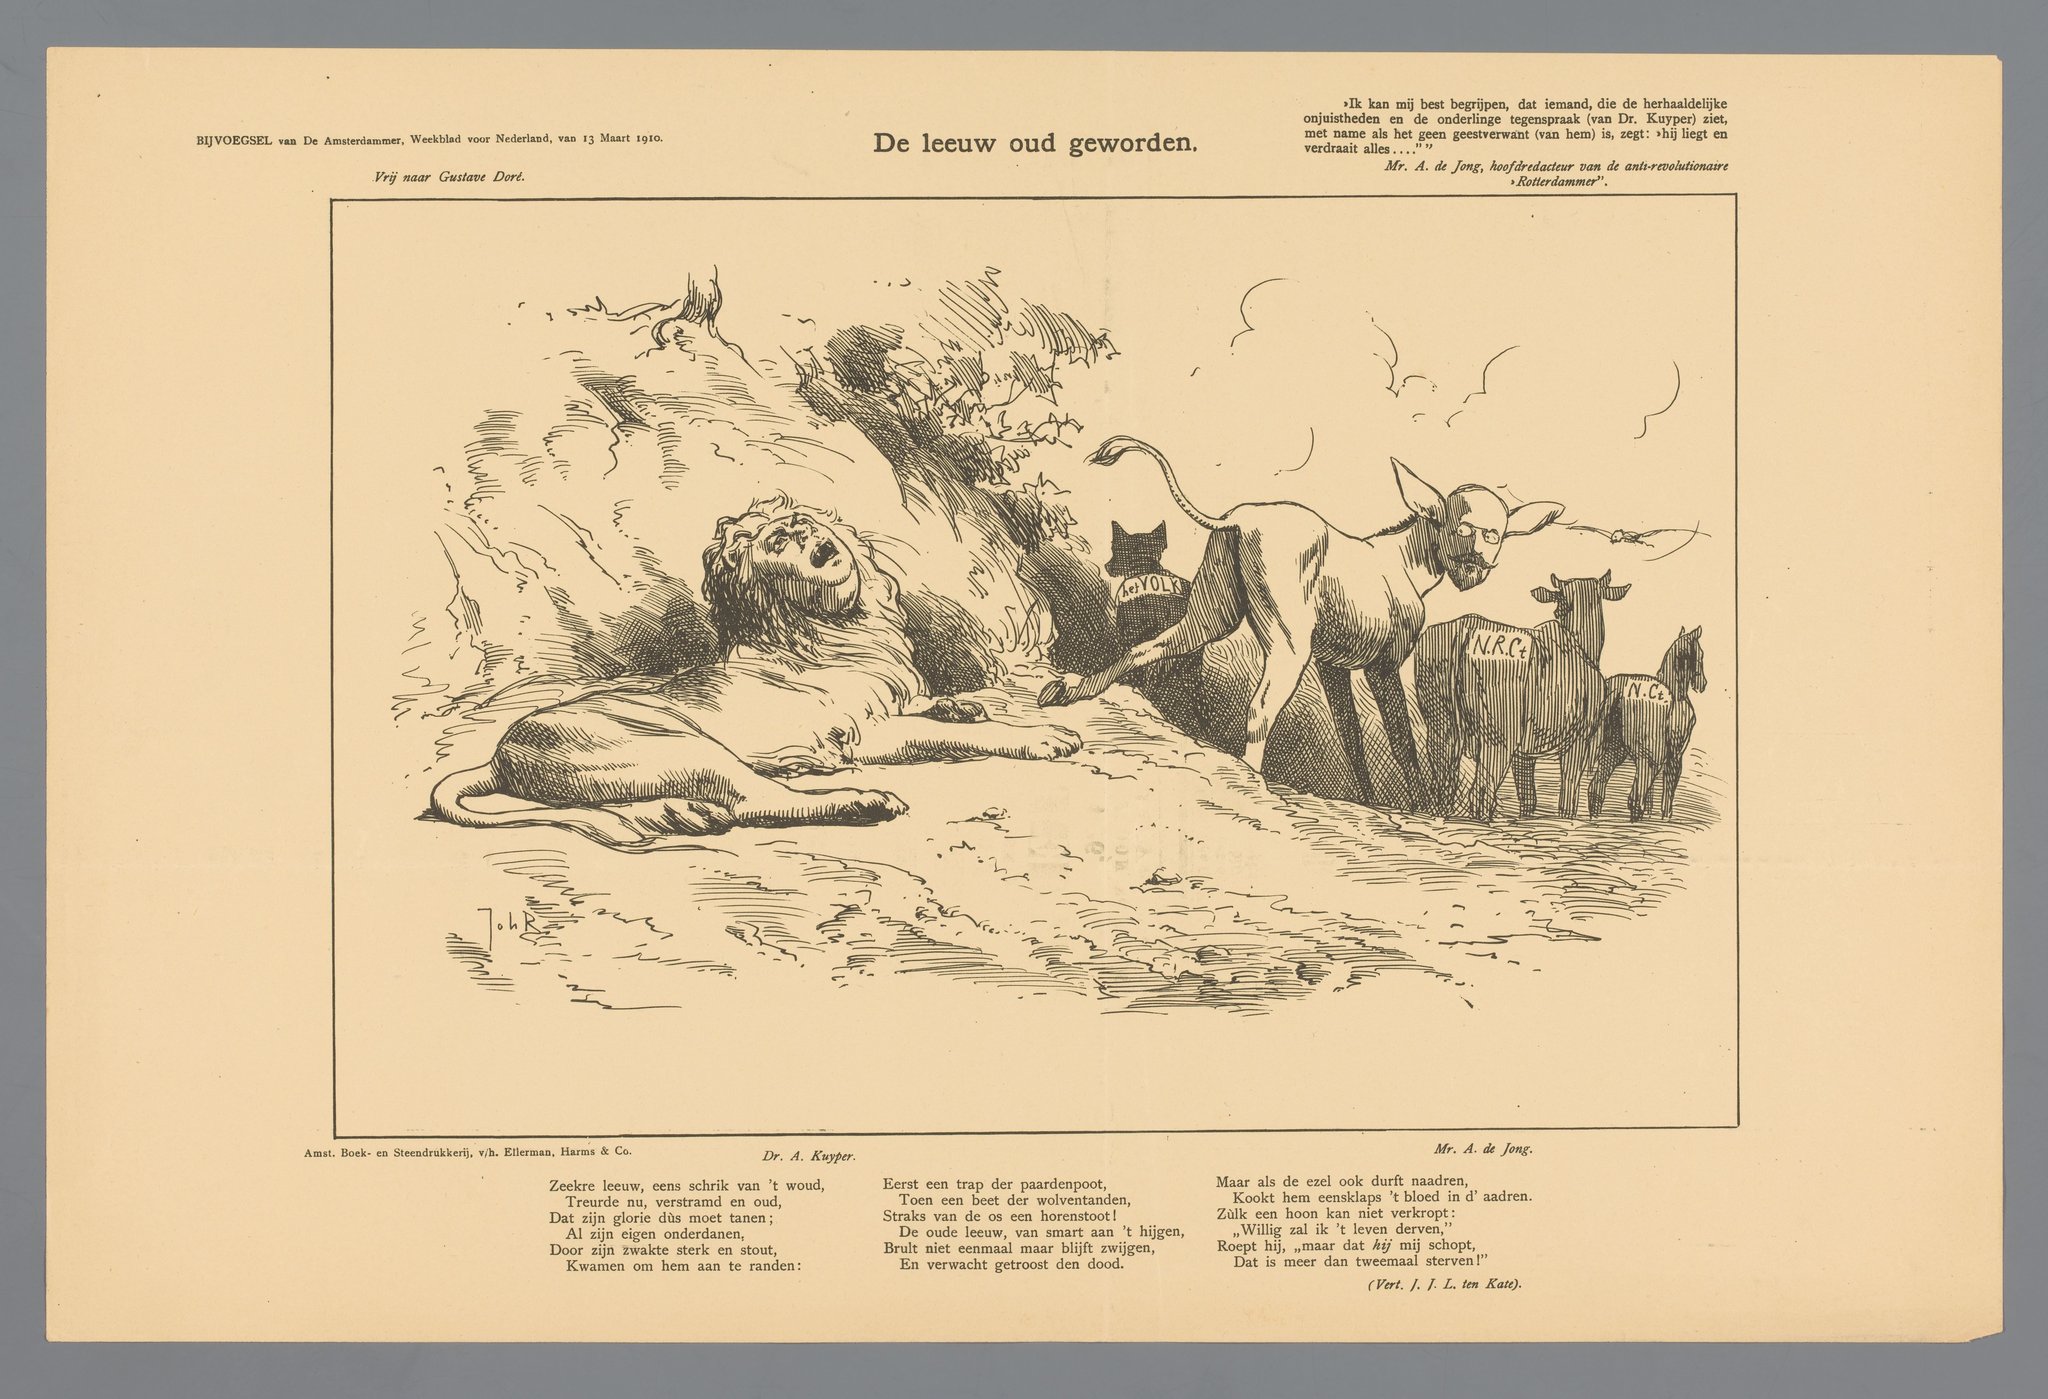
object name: cartoon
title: De leeuw oud geworden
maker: johan braakensiek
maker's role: draughtsman, print maker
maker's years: 1858-1940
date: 1910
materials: paper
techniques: lithograph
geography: amsterdam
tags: the hague, abraham kuyper, press, journalism, historical persons, beasts of prey, predatory animals: lion, political caricatures and satires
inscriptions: date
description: Prent uit het bijvoegsel van: De Amsterdammer. Weekblad voor Nederland, 13 maart 1910.